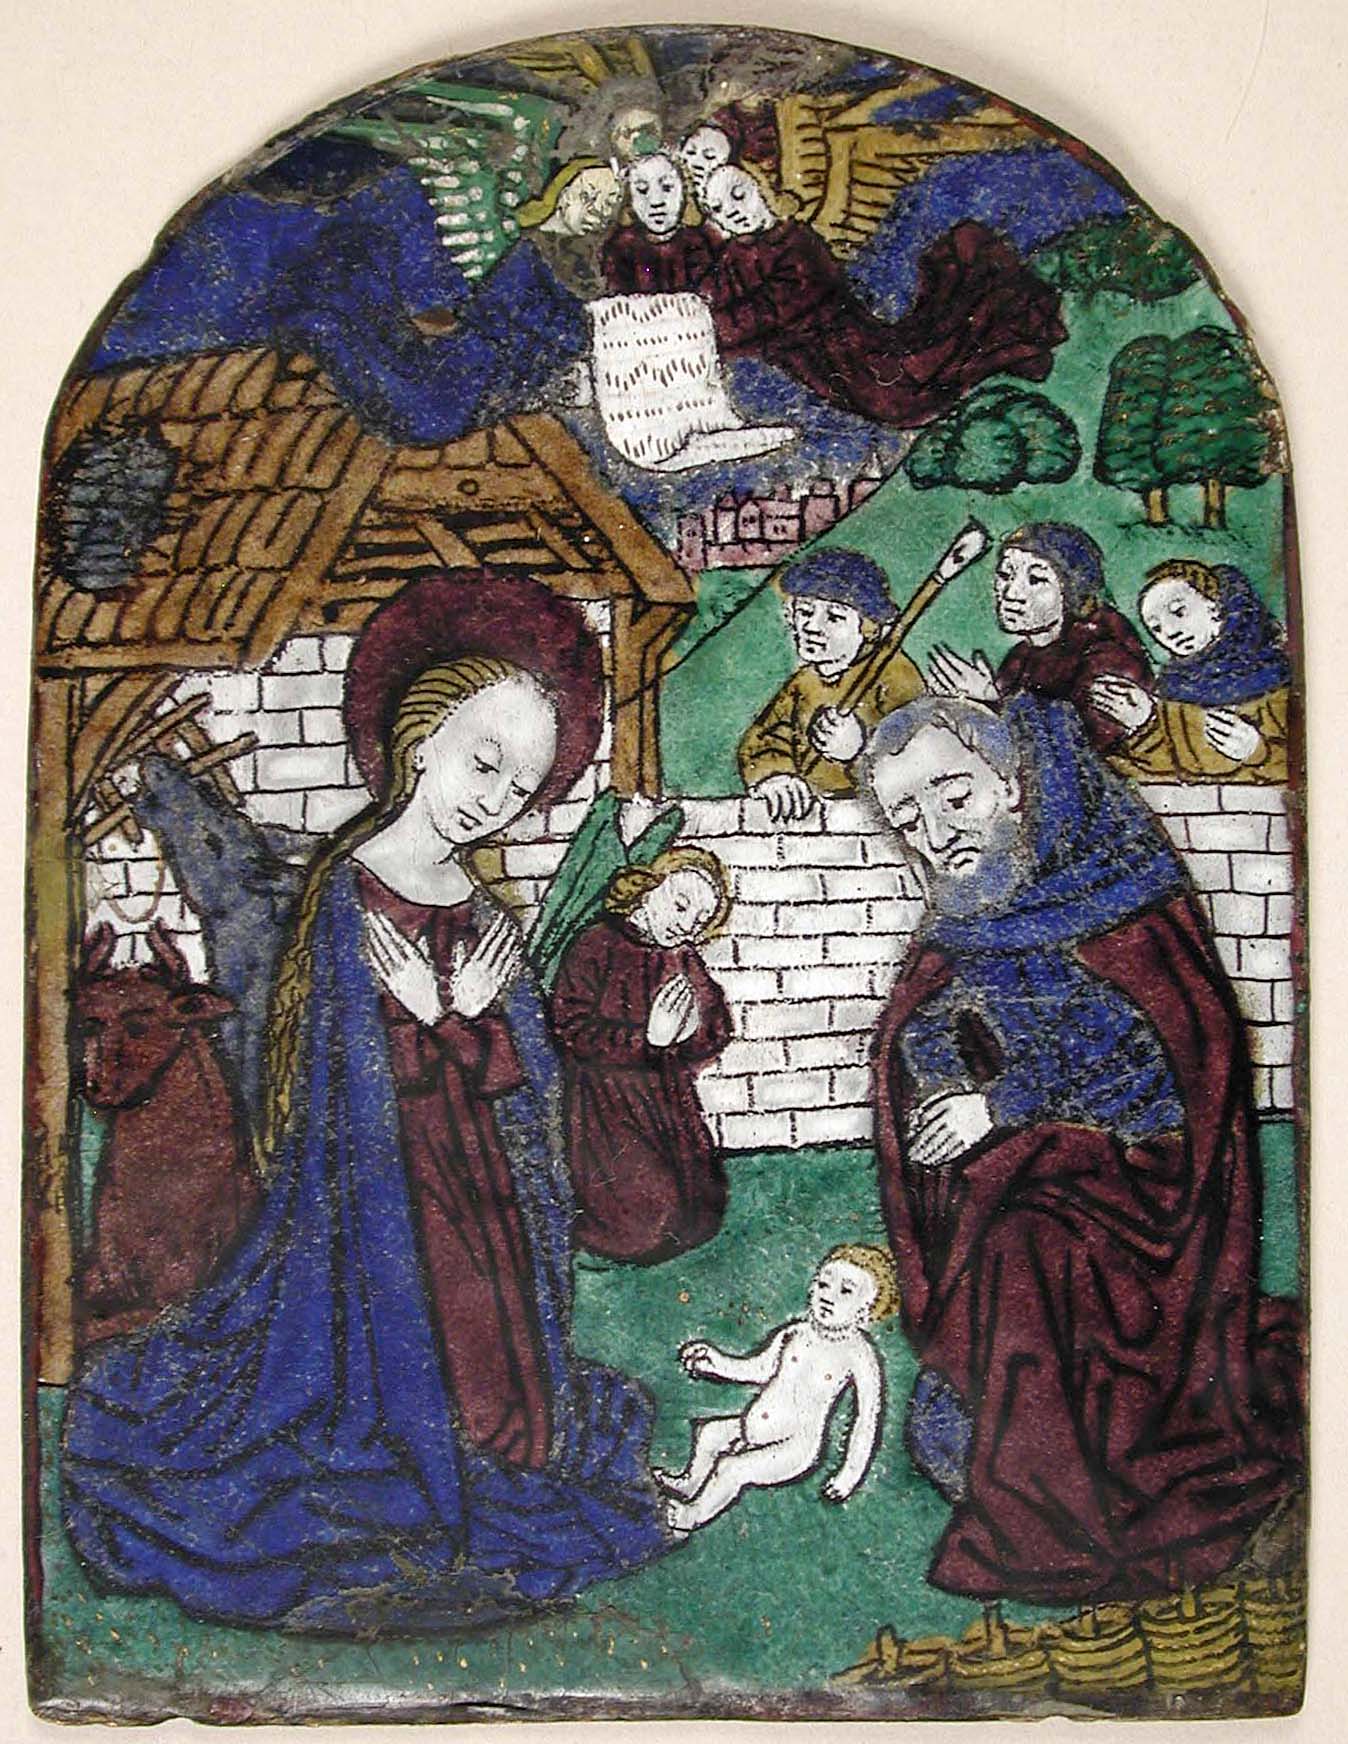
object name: plaque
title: Plaque with Adoration of the Shephards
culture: french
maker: monvaerni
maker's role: artist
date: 1401-1500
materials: copper, enamel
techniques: painting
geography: france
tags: angels,christ,adoration of the shepherds